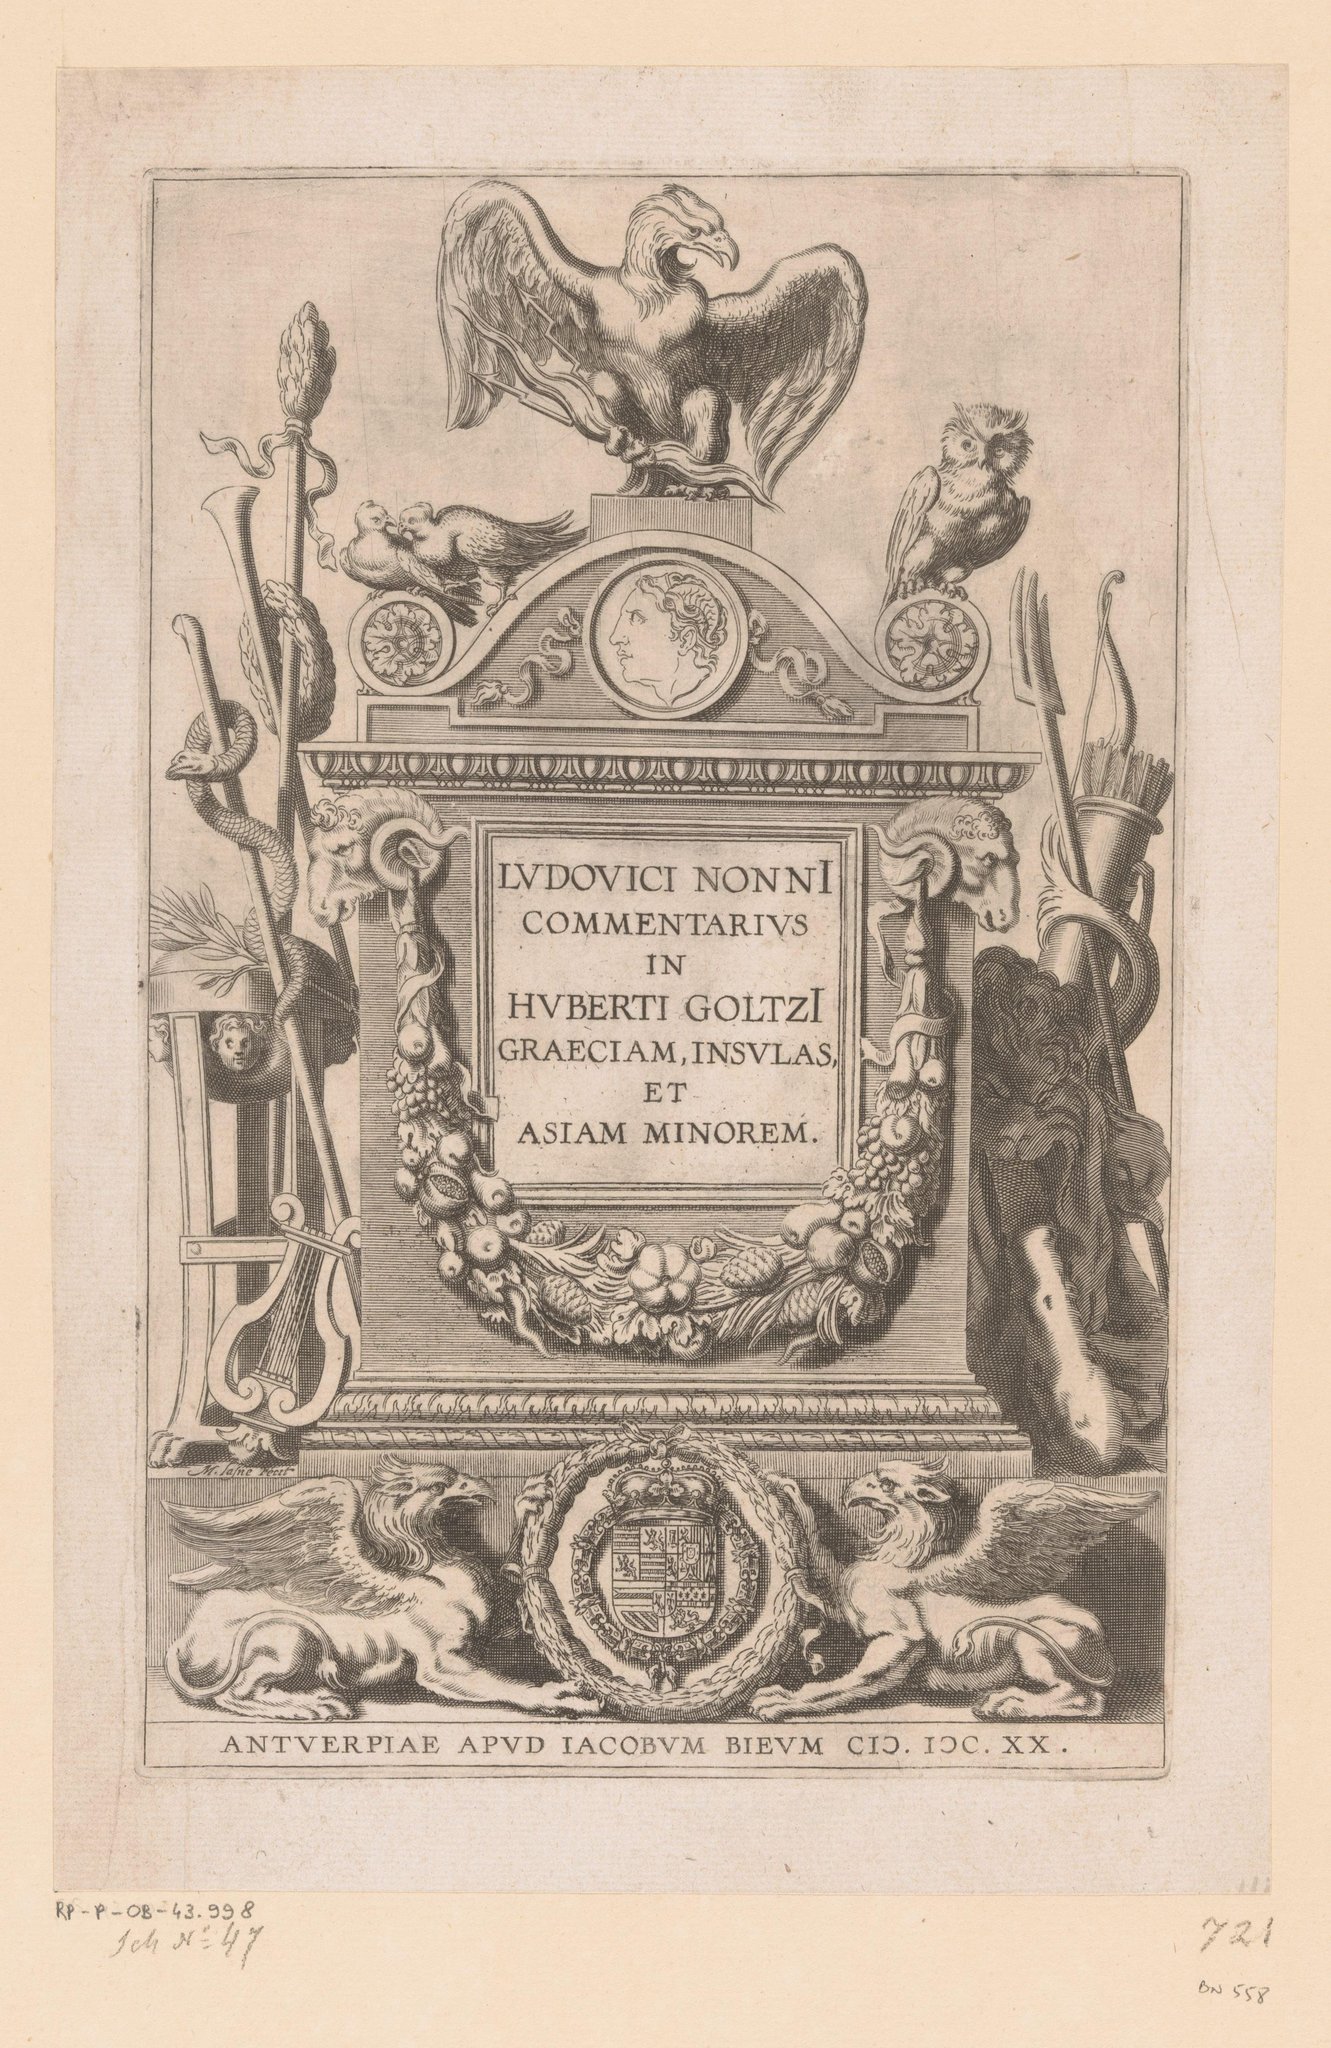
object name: print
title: Klassiek altaar met griffioenen, een guirlande en de attributen van verschillende klassieke goden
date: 1600-1641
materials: paper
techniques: engraving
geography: antwerp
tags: griffin (lion/eagle); 'griffo' (ripa), altar ~ greek religion, attributes of minerva: owl, attributes of jupiter: eagle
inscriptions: collector's mark: Lugt 240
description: Titelpagina voor: Nonnius, Ludovicus. Commentarivs In Hvberti Goltzi Graeciam, Insvlas, Et Asiam Minorem. Antwerpen: Jacques de Bie, 1620. De prent werd initieel gebruikt als titelpagina voor de 'Graeciae universae Asiaeque Minoris et Insularum Nomismata', uitgegeven door Jacques de Bie in 1618 te Antwerpen.